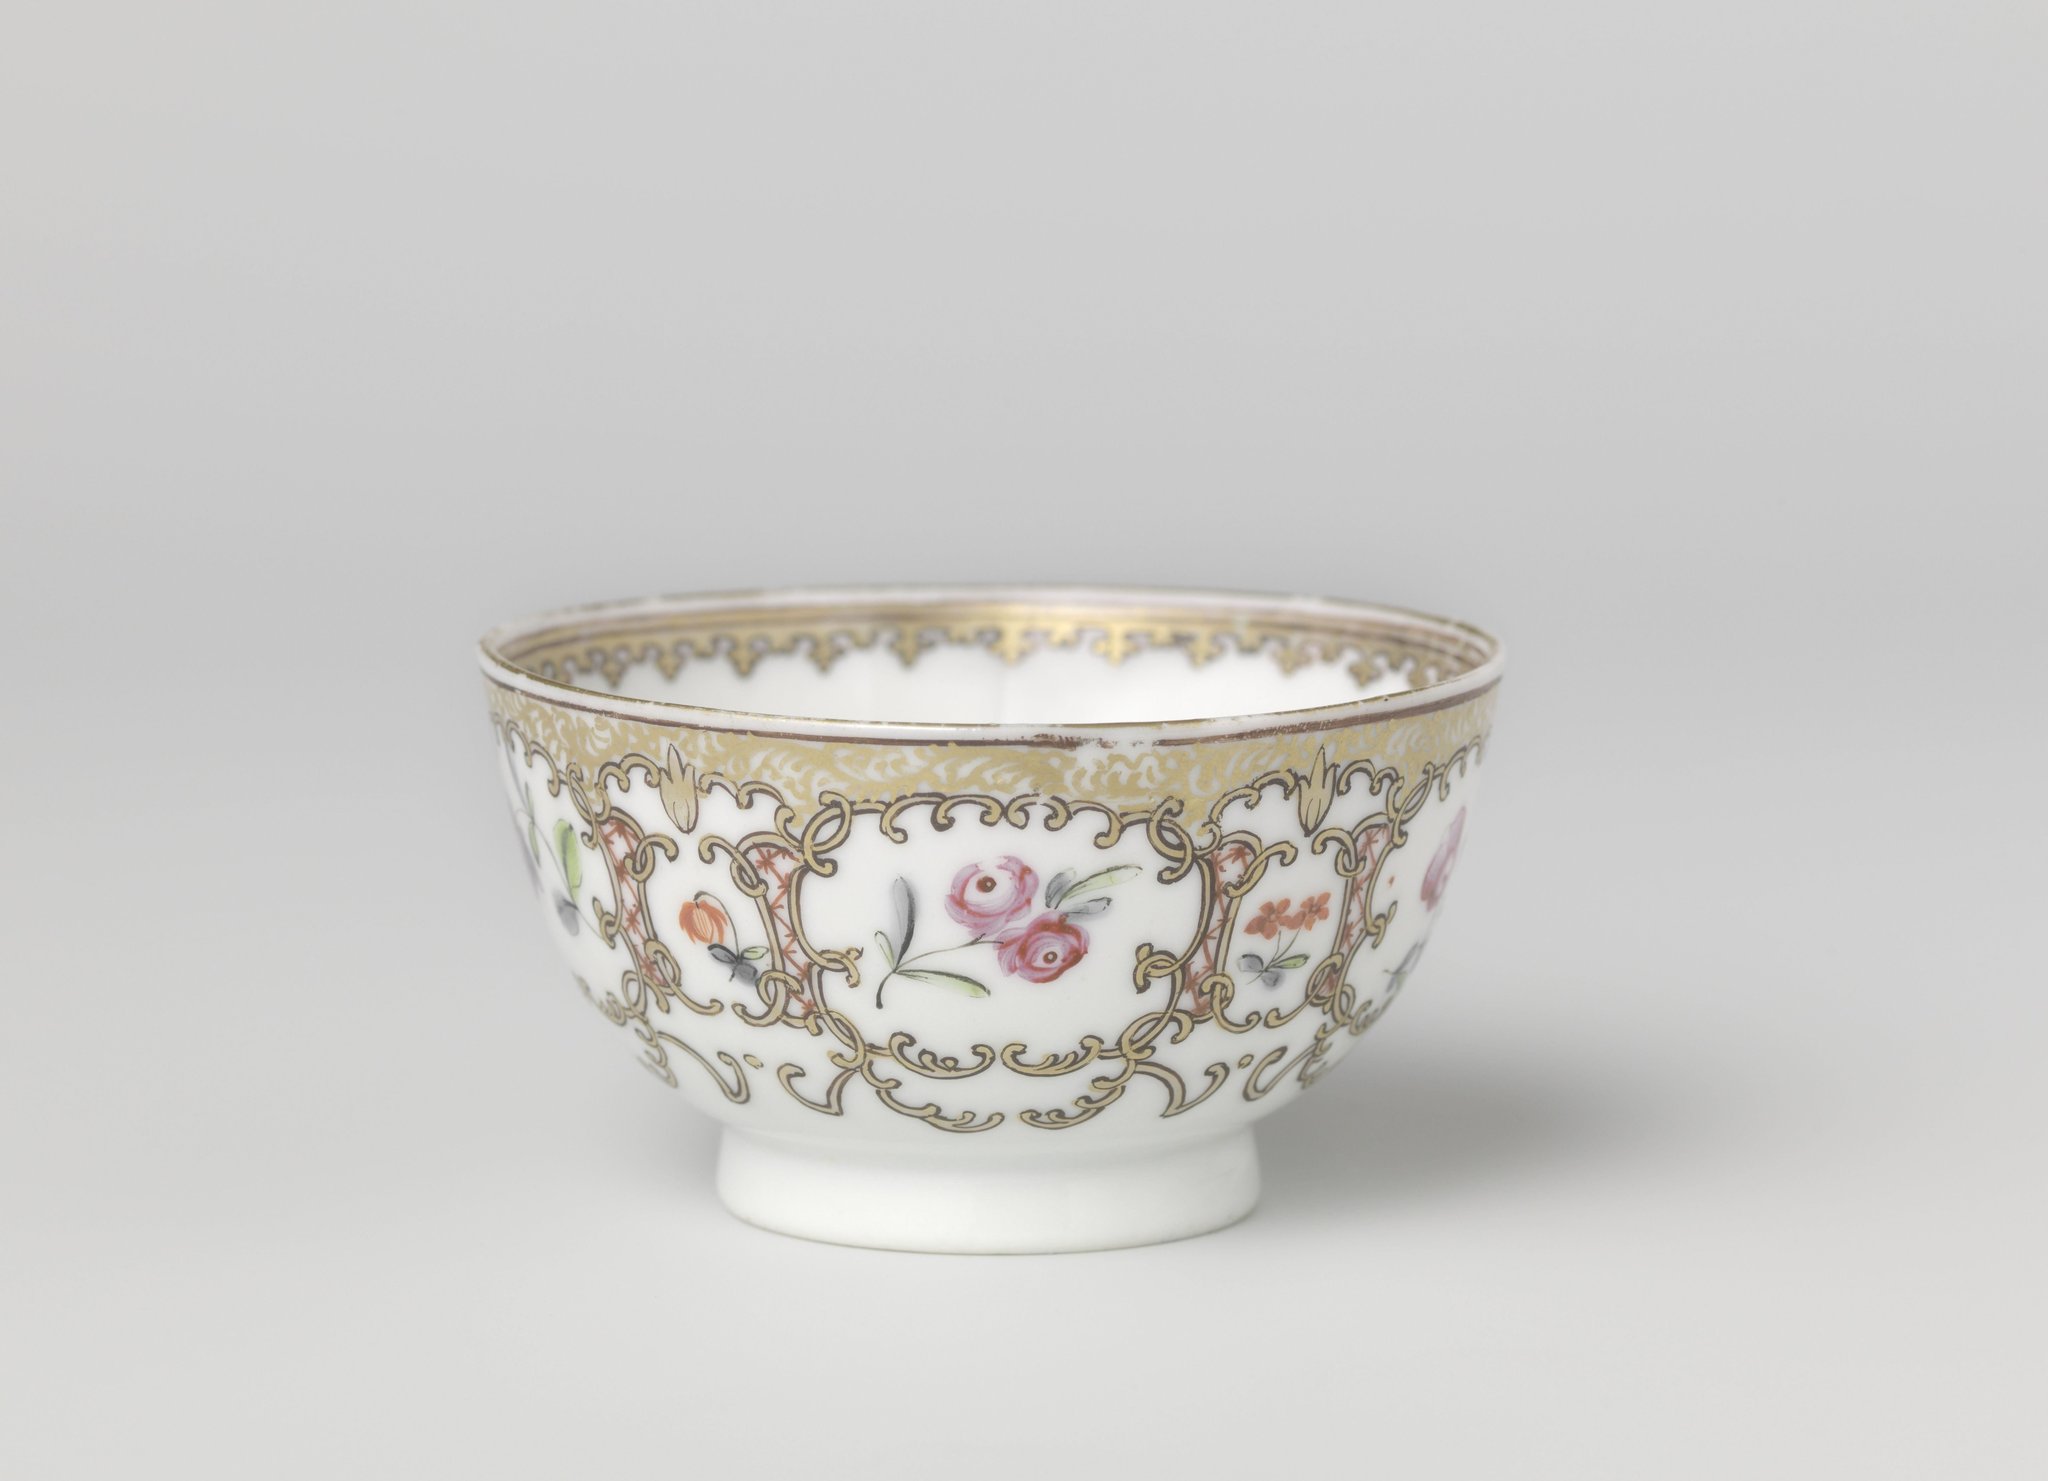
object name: cup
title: Cup with flower sprays and panels made from scrolls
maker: Anonymous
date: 1750-1774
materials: glaze, gold, paint, porcelain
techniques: firing, gilding, turning, vitrification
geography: china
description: Kop, versierd met gekleurde bloemen en gouden randen.